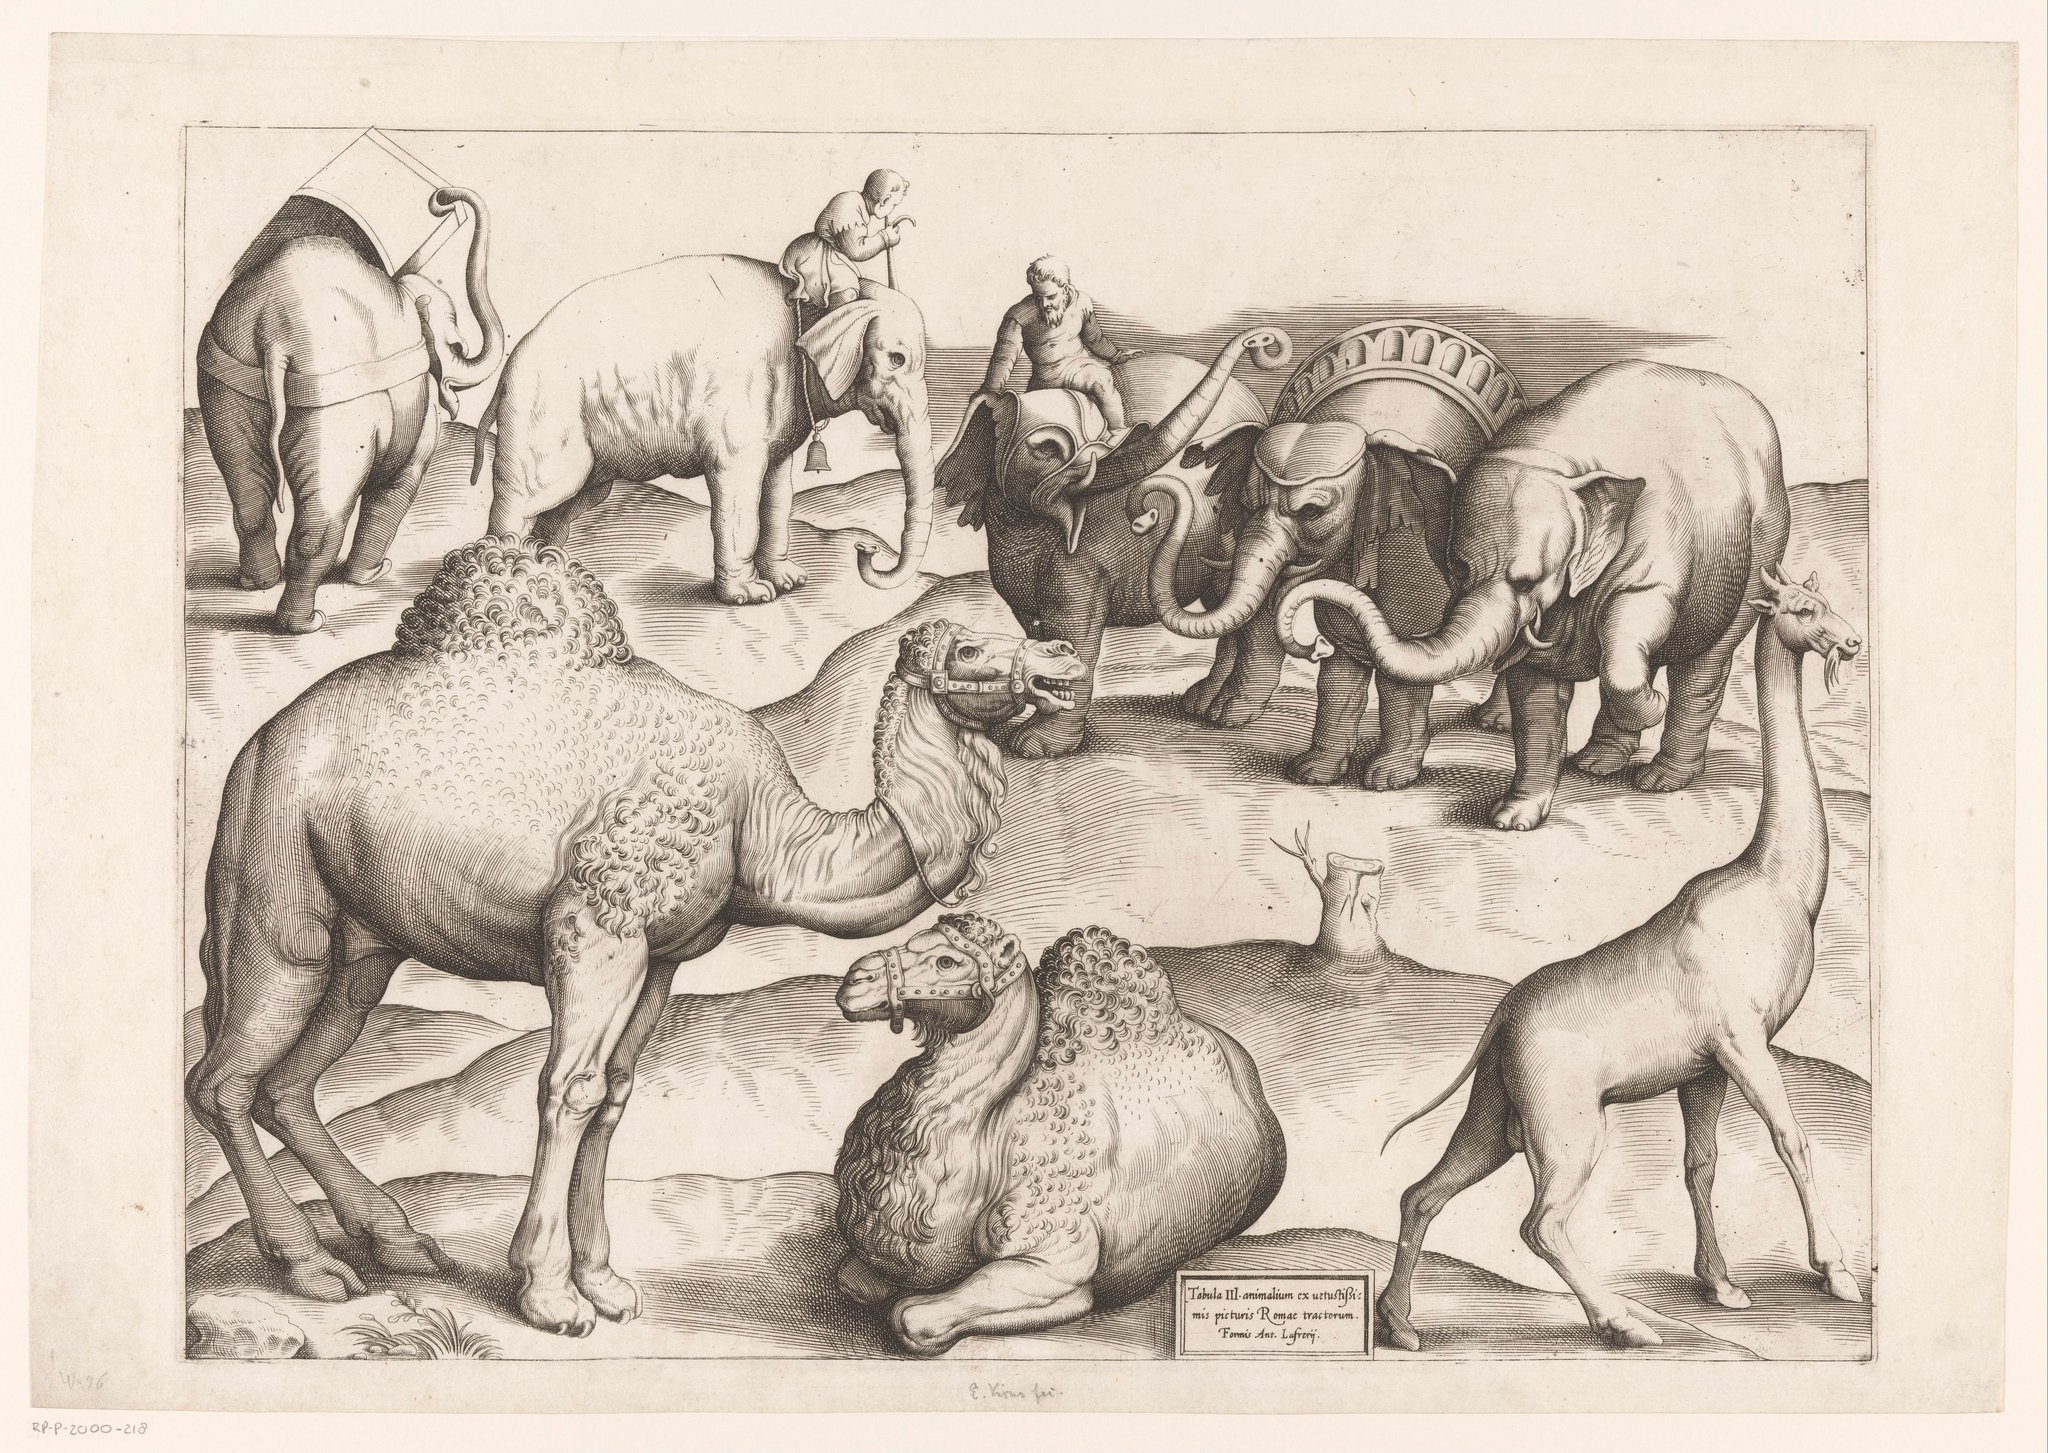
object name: print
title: Dieren naar antieke muurschilderingen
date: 1547-1577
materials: paper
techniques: engraving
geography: italy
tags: mammals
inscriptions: collector's mark: Lugt 2760, collector's mark: Lugt 2228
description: Prent uit een reeks van drie prenten met voorstellingen van dieren. Volgens het opschrift op prent nummer I werden de prenten vervaardigd naar in 1547 ontdekte schilderingen in een hypocaustum. Deze prent behoort tot het prentcorpus dat bekend staat als de ‘Speculum Romanae Magnificentiae’ (‘Spiegel van Romeinse pracht’). Dit corpus, bestaande uit prenten met voorstellingen van kunstwerken en gebouwen uit het antieke en het moderne Rome, vond zijn oorsprong bij uitgevers Antonio Salamanca en Antonio Lafreri. Deze twee buitenlandse uitgevers bundelden hun krachten te Rome in de periode 1553-1563. Hun prenten werden al snel razend populair bij toeristen en verzamelaars, die de prenten individueel of in grote groepen aanschaften. Grote groepen Speculum-prenten werden vaak op aanvraag samengebonden in albums. Er zijn verschillende Speculum-albums overgeleverd die allemaal verschillen van inhoud. Tussen 1573 en 1577 gaf Antonio Lafreri een speciale titelpagina uit (met de titel ‘Speculum Romanae Magnificentiae’) die mensen voor hun verzamelingen konden voegen. Het overlijden van Lafreri in 1577 betekende niet het einde van het corpus. Een groot deel van de koperplaten ging over op Claudio en Stefano Duchetti. De rest raakte verspreid over verschillende andere uitgevers. De populariteit van de Speculum-prenten wist nog geruime periode uitgevers te inspireren tot het laten maken van kopieën en het toevoegen van nieuwe prenten aan het corpus.